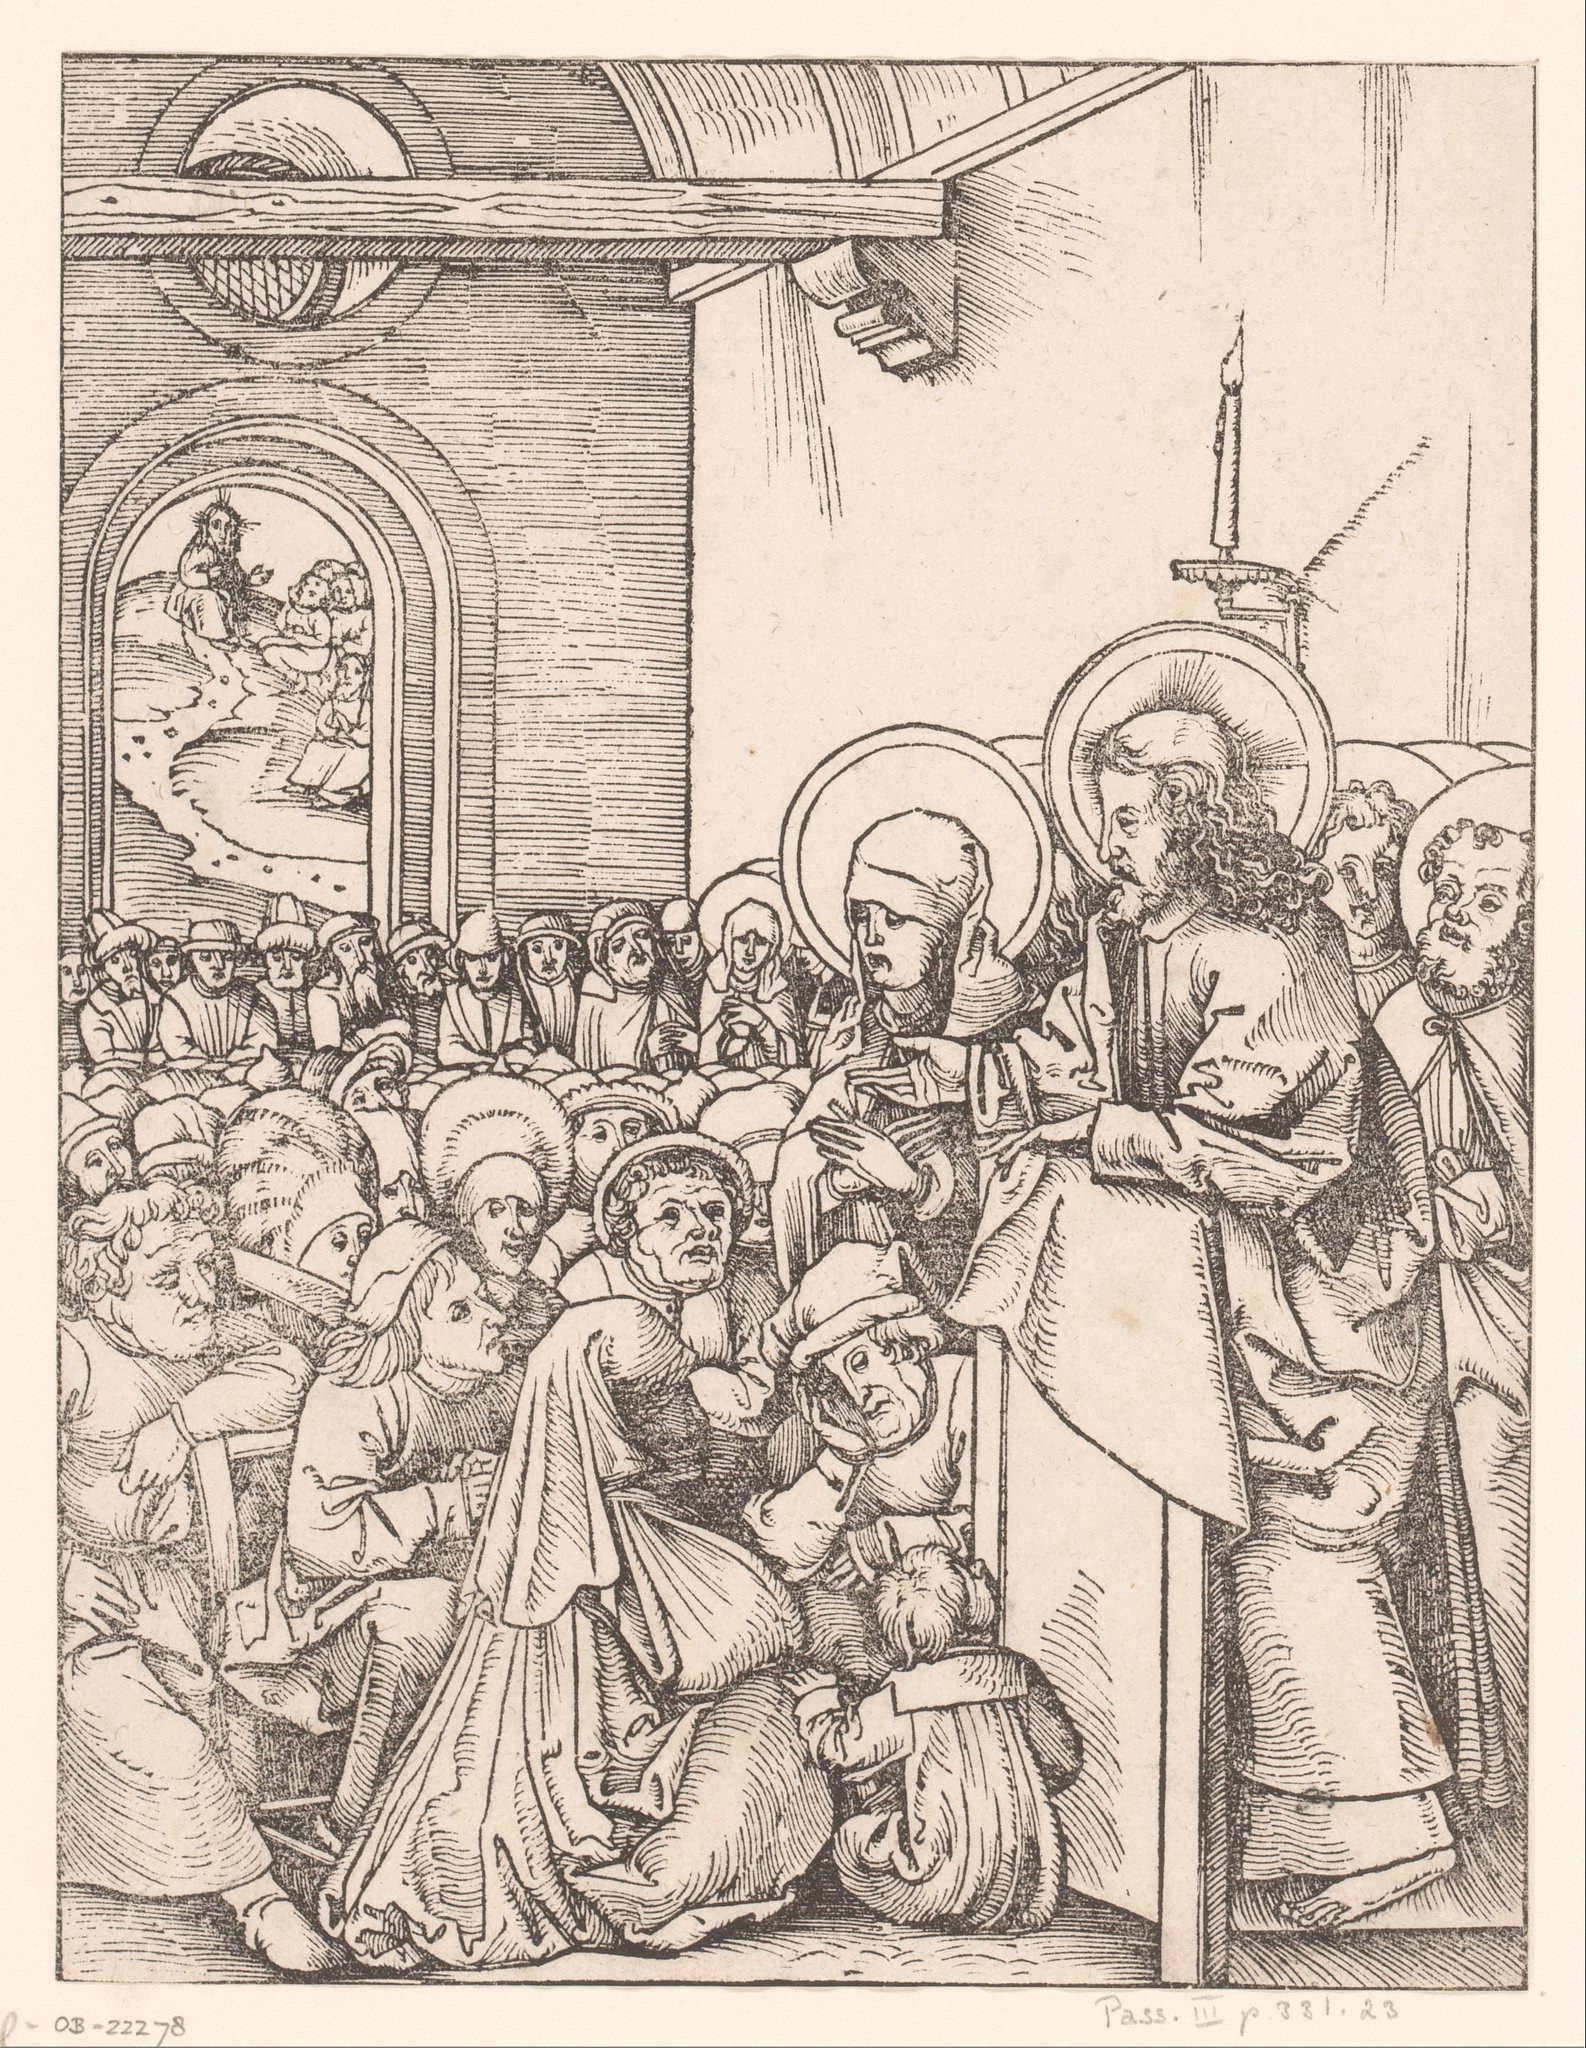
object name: print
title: Bijbelse voorstellingen, 13 (43)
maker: Anonymous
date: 1490-1526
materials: paper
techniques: woodcut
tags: christ preaching or teaching (in general), christ's sermon on the mount (matthew 5-7)